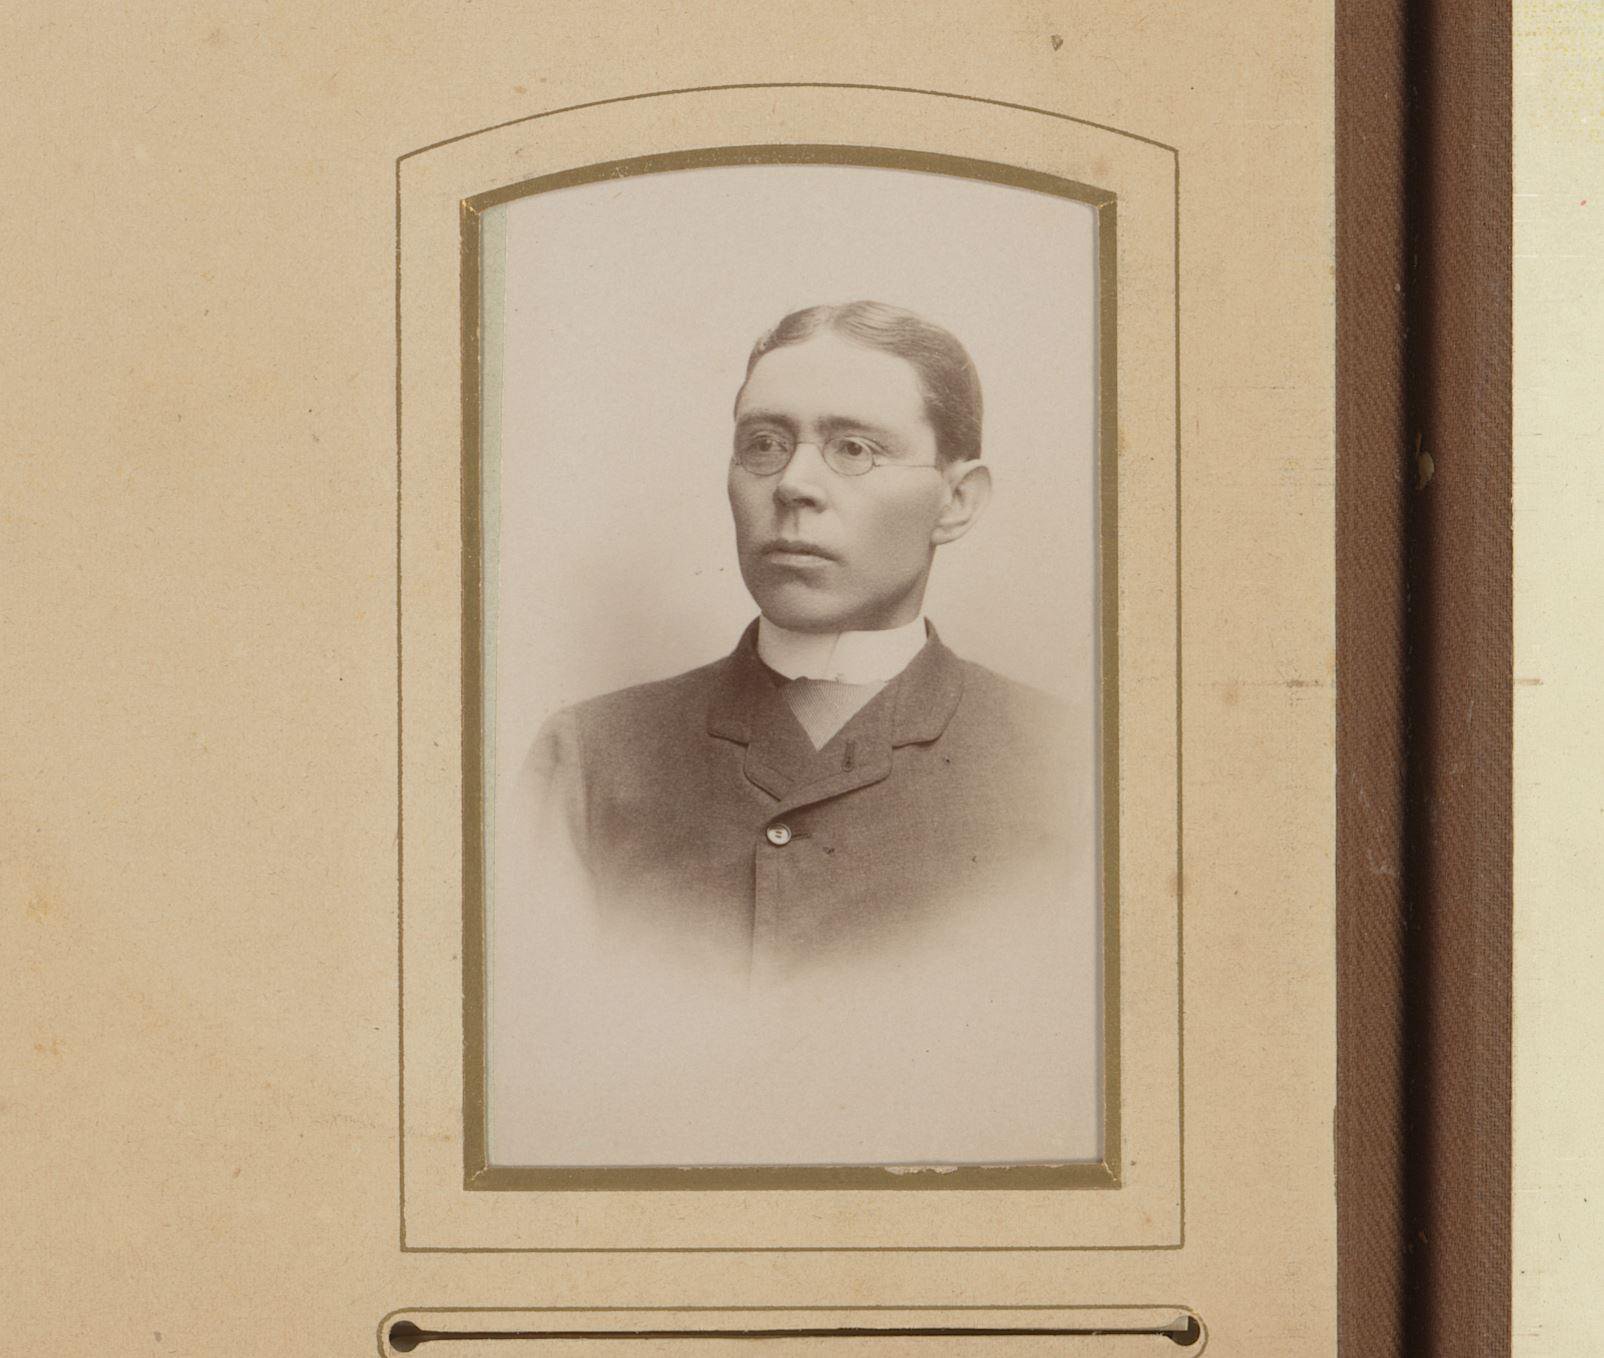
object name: photograph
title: Portret van een geestelijke met bril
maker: léonard hubert zeyen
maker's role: fotograaf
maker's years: 1840-1907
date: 1880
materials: cardboard, photographic support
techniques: albumen print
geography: liège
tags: eyeglasses, spectacles, historical persons, organization, functionaries and dignitaries in roman catholic church; clergy in general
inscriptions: inscription: ‘L. H. Zeyen/ Liège.’